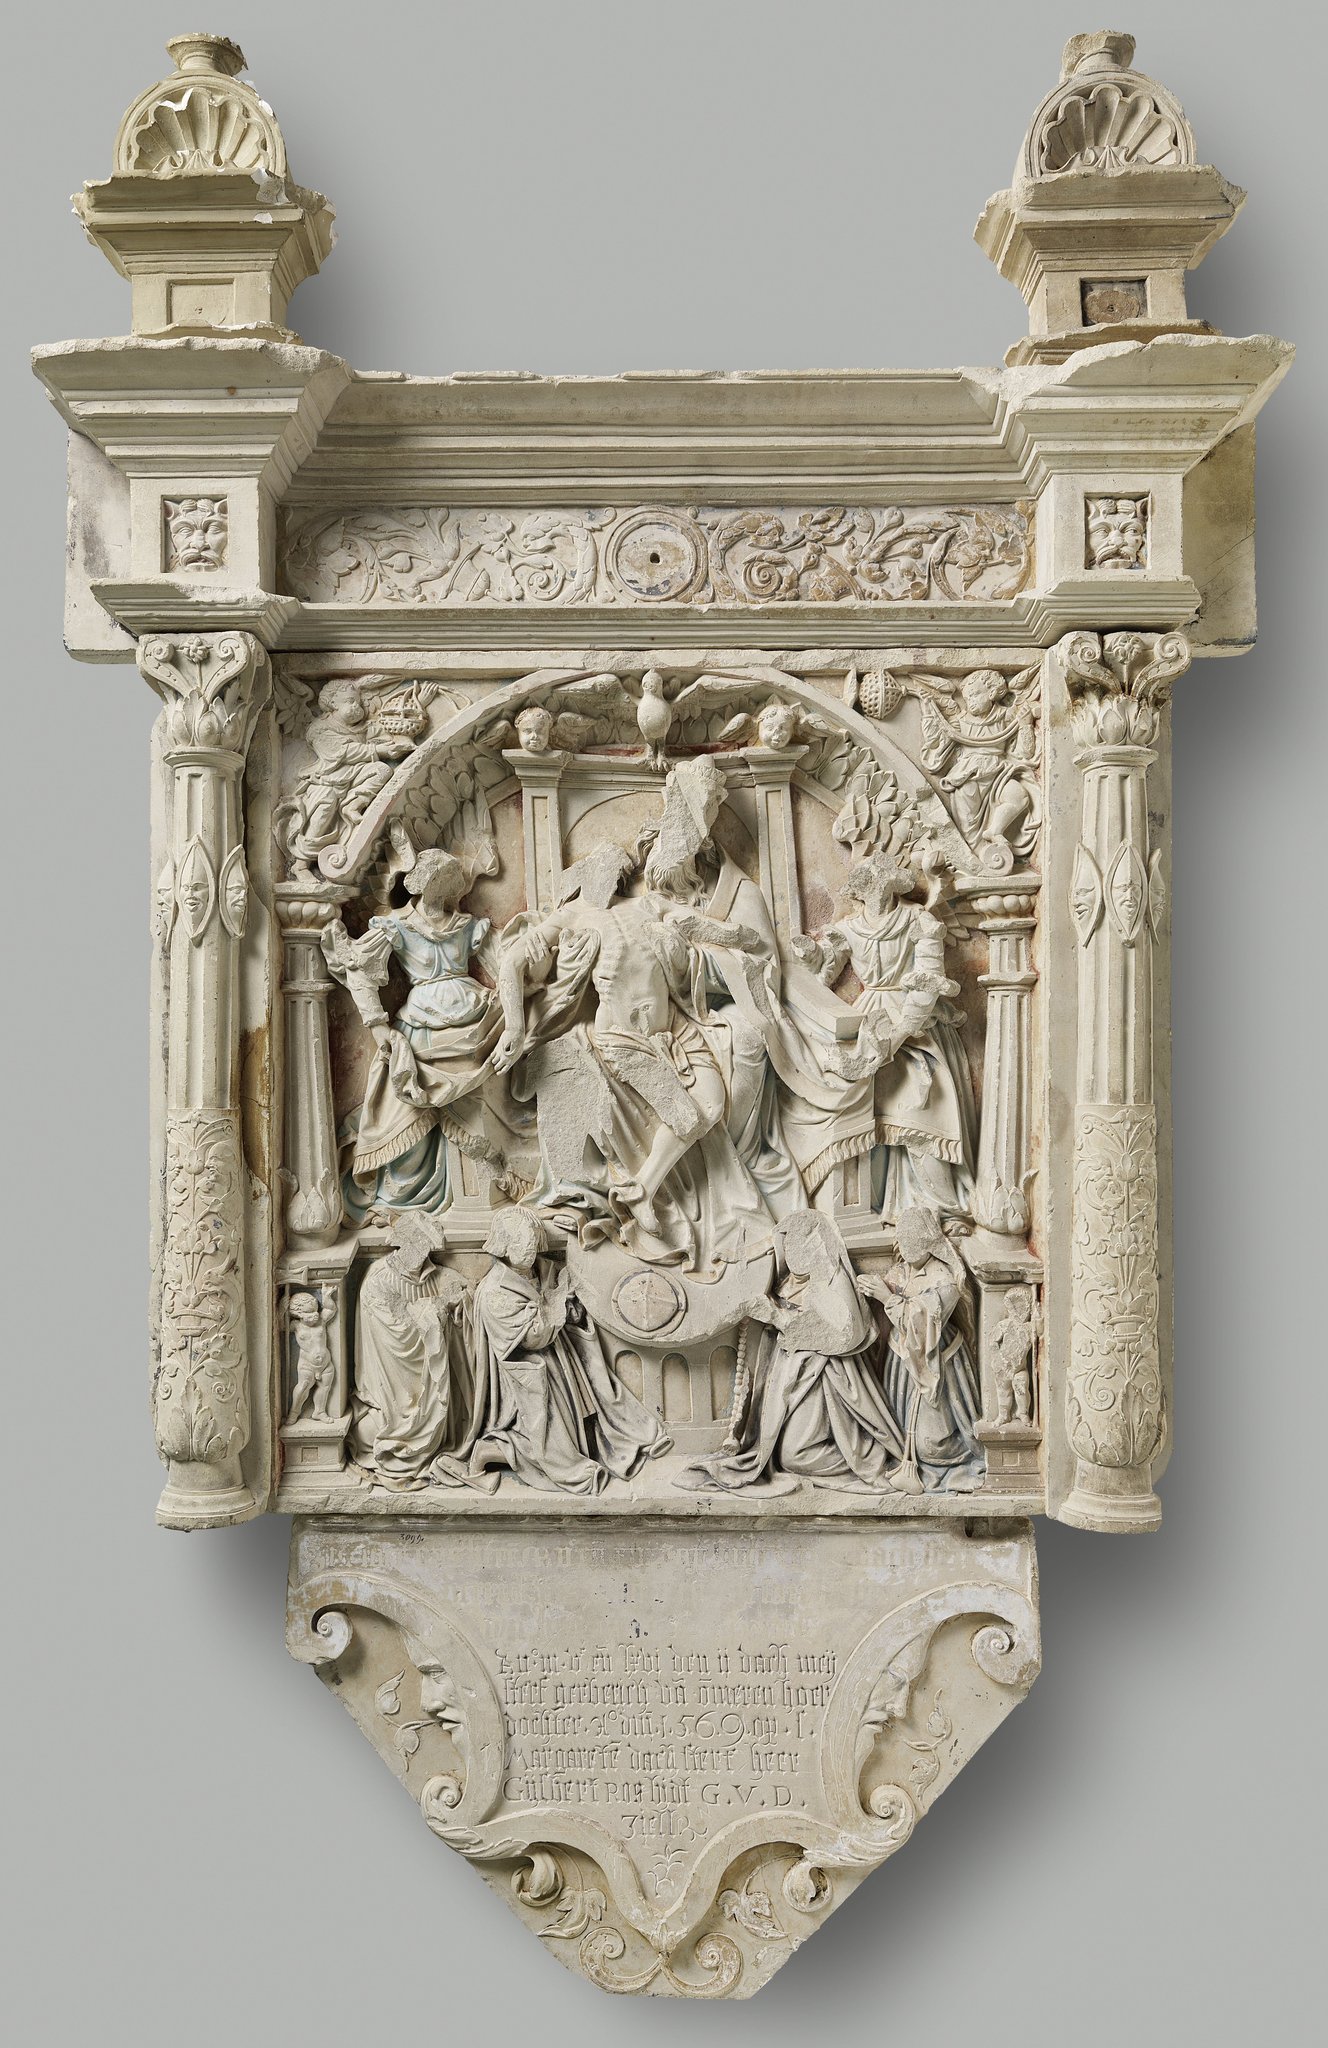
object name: relief sculpture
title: Rechterzuil van epitaaf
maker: arnt van tricht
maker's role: sculptor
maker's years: -1570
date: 1548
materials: stone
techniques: polychromy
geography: kalkar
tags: wageningen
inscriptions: inscription: ‘INT IAER ONS HERE MVcXLVIII OP SINTE EGIDII DACH STERF DERRICK ROS / Ao DNI VC o STERF NERTWICH SIJN HUYSFROU o SIEL’, inscription: ‘ANo MVc EN LXVI DEN II DACH MEIJ STERF GERBERICH VA OMEREN HOOR DOCHTER / Ao DOMINI 1569 OP S: MARGARETE DACH STERF HEER GIJSBERT ROS Bidt G.V.D. ZIELL’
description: Onderdeel van epitaaf van de familie Ros uit de Grote Kerk te Wageningen.